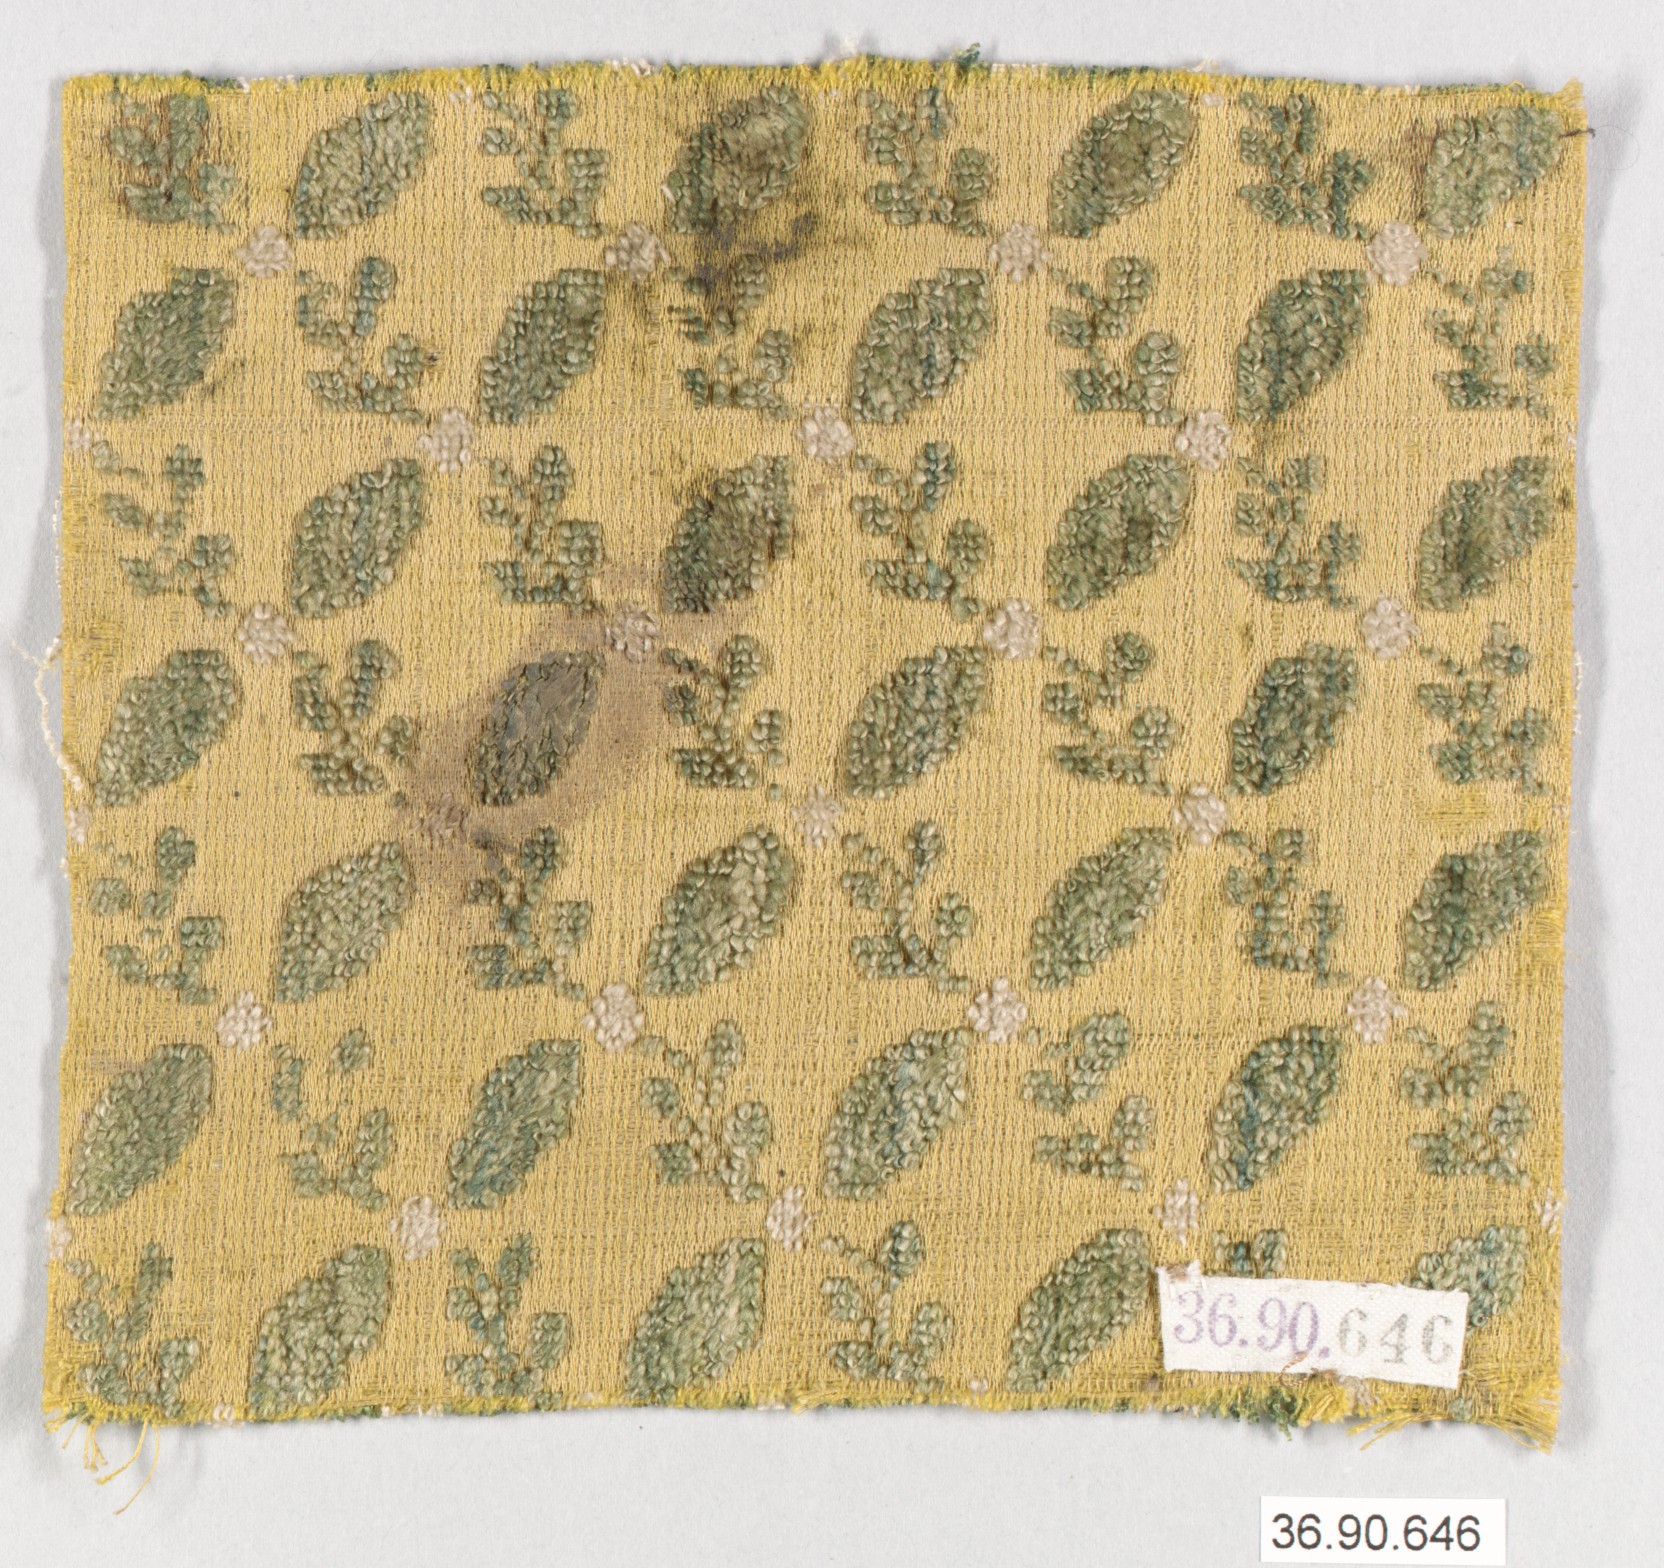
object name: piece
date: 1501-1700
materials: metal thread, silk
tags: leaves